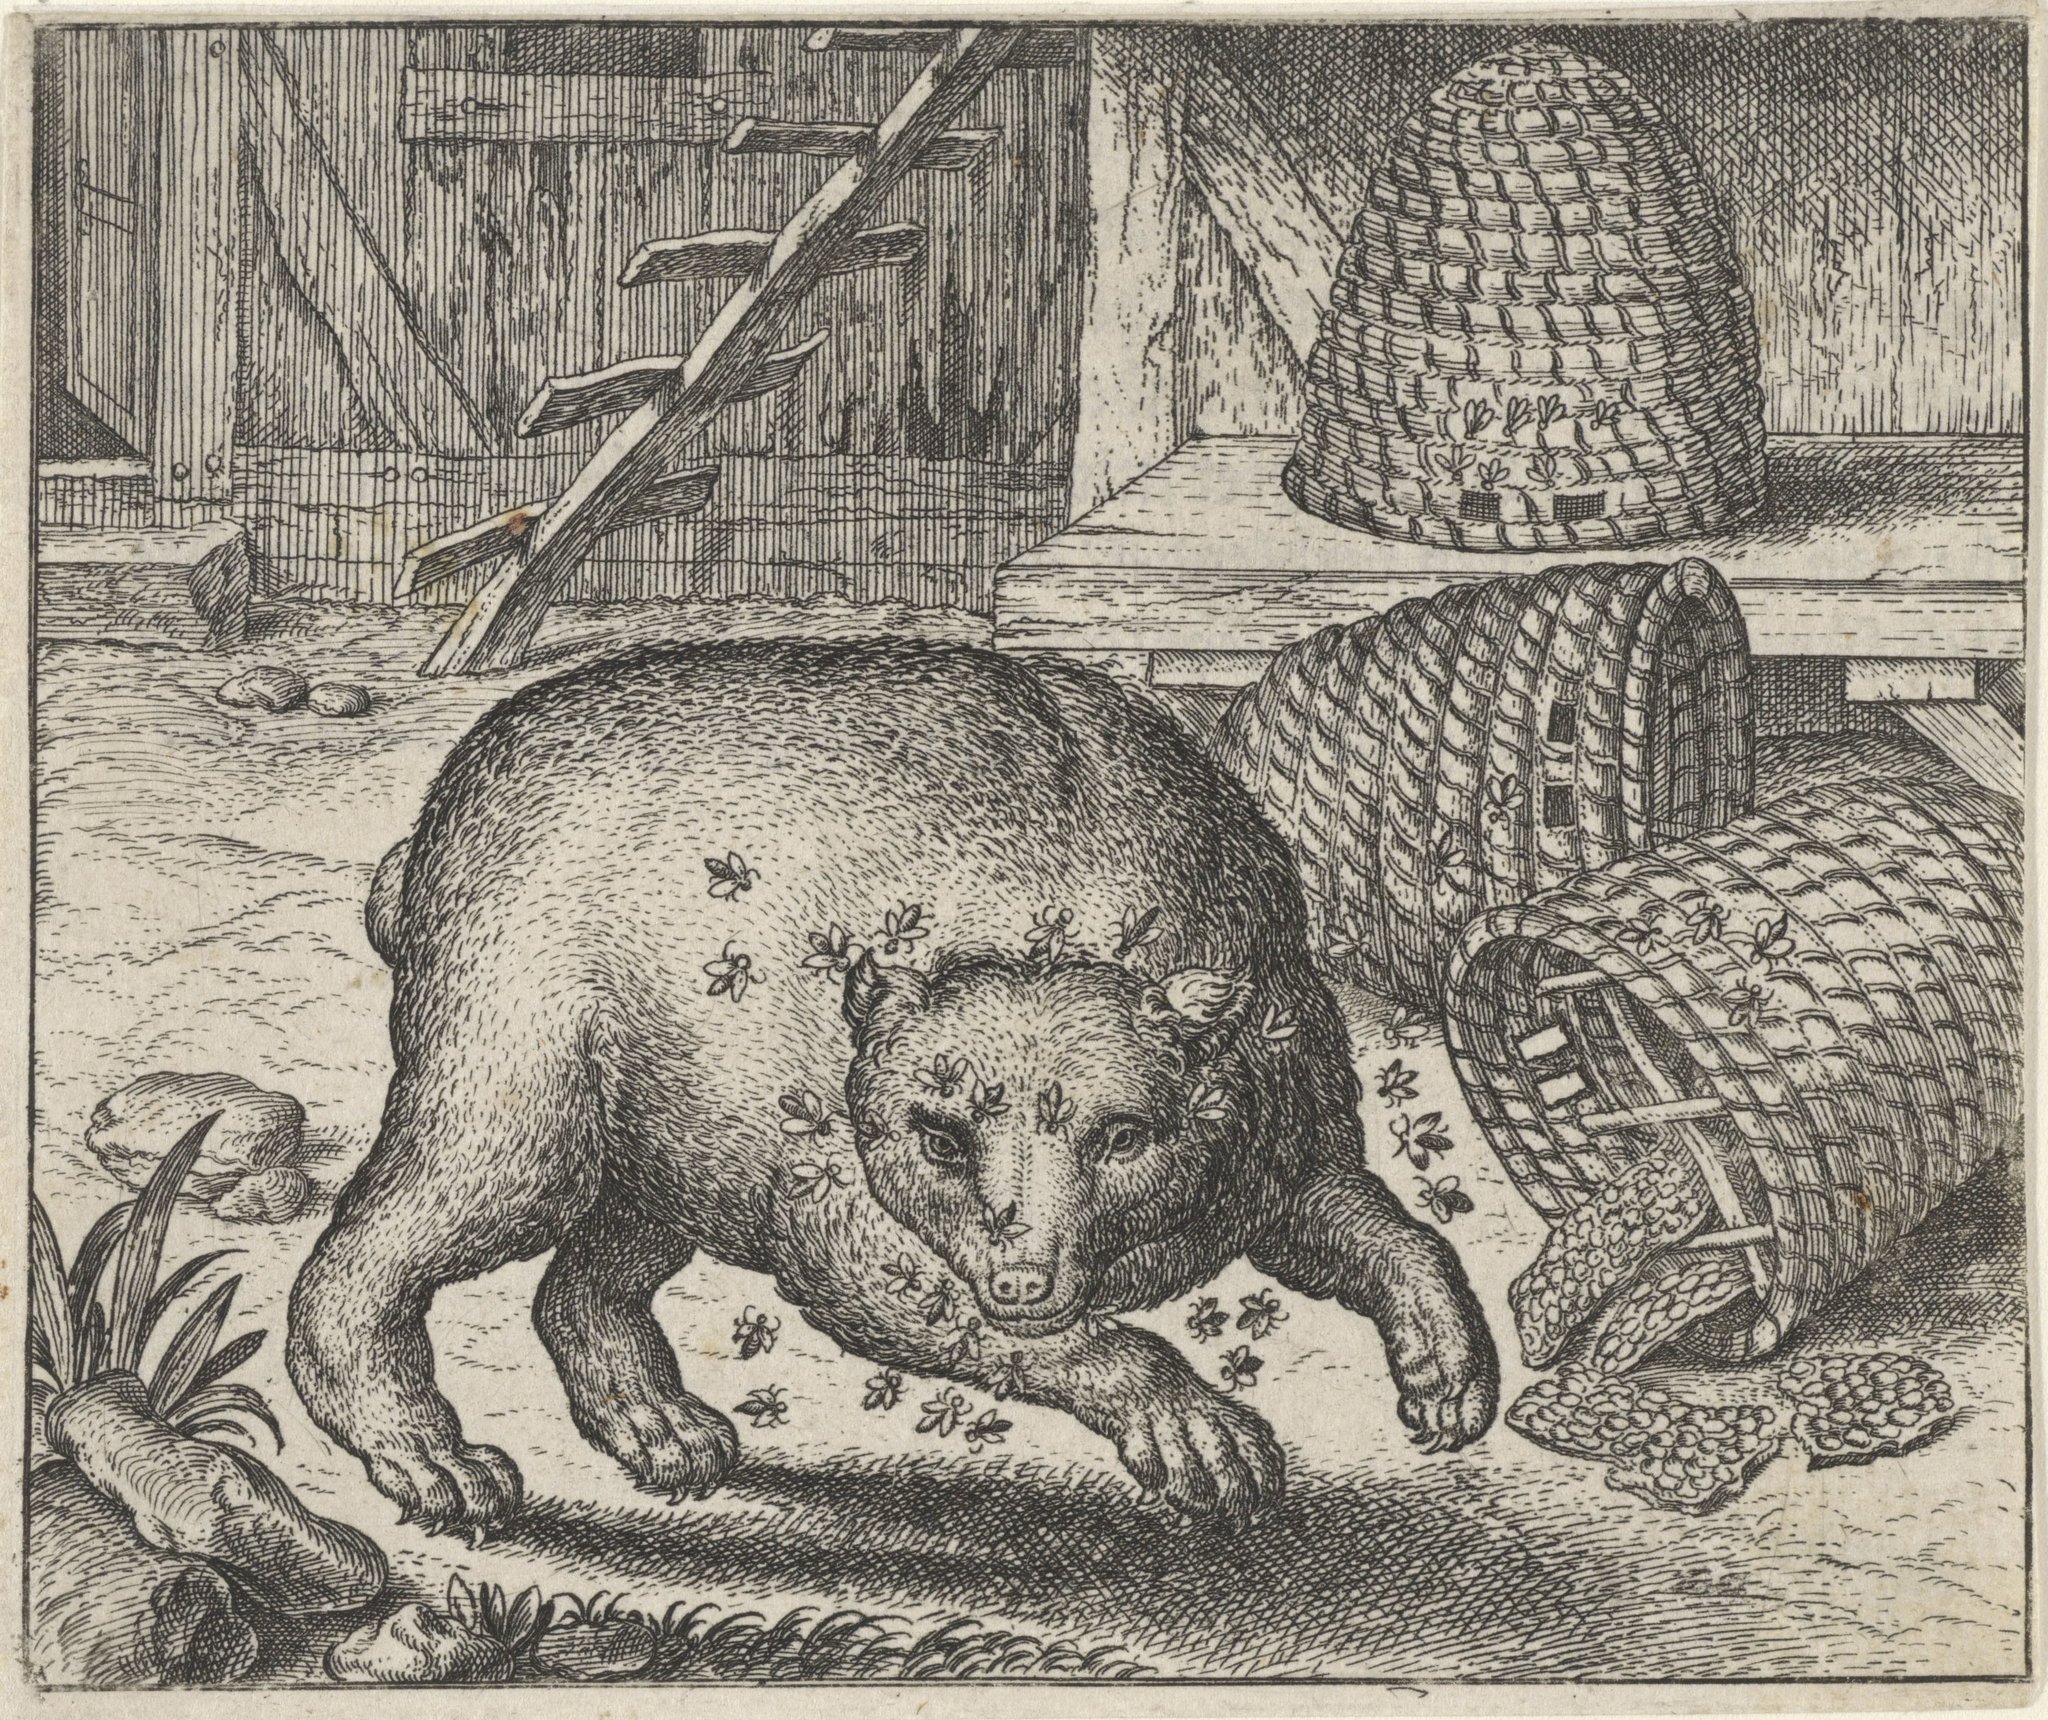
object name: book illustration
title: Fabel van de beer en de bijen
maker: aegidius sadeler (ii)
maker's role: draughtsman, print maker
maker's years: 1568-1629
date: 1608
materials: paper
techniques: engraving, etching, letterpress printing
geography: prague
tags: fables of aesop (bear and the bees) : use 85(...), beasts of prey, predatory animals: bear, bee-hive, insects: bee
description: Een beer bij drie bijenkorven. Hij is gestoken door een bij en heeft in zijn woede één van de korven laten omvallen. Hij wordt daarom aangevallen door de bijen die uit de omgevallen korf zwermen. De moraal van het verhaal leert dat het beter is lijdzaam dingen te aanvaarden, dan wraak te zoeken en meer te lijden.